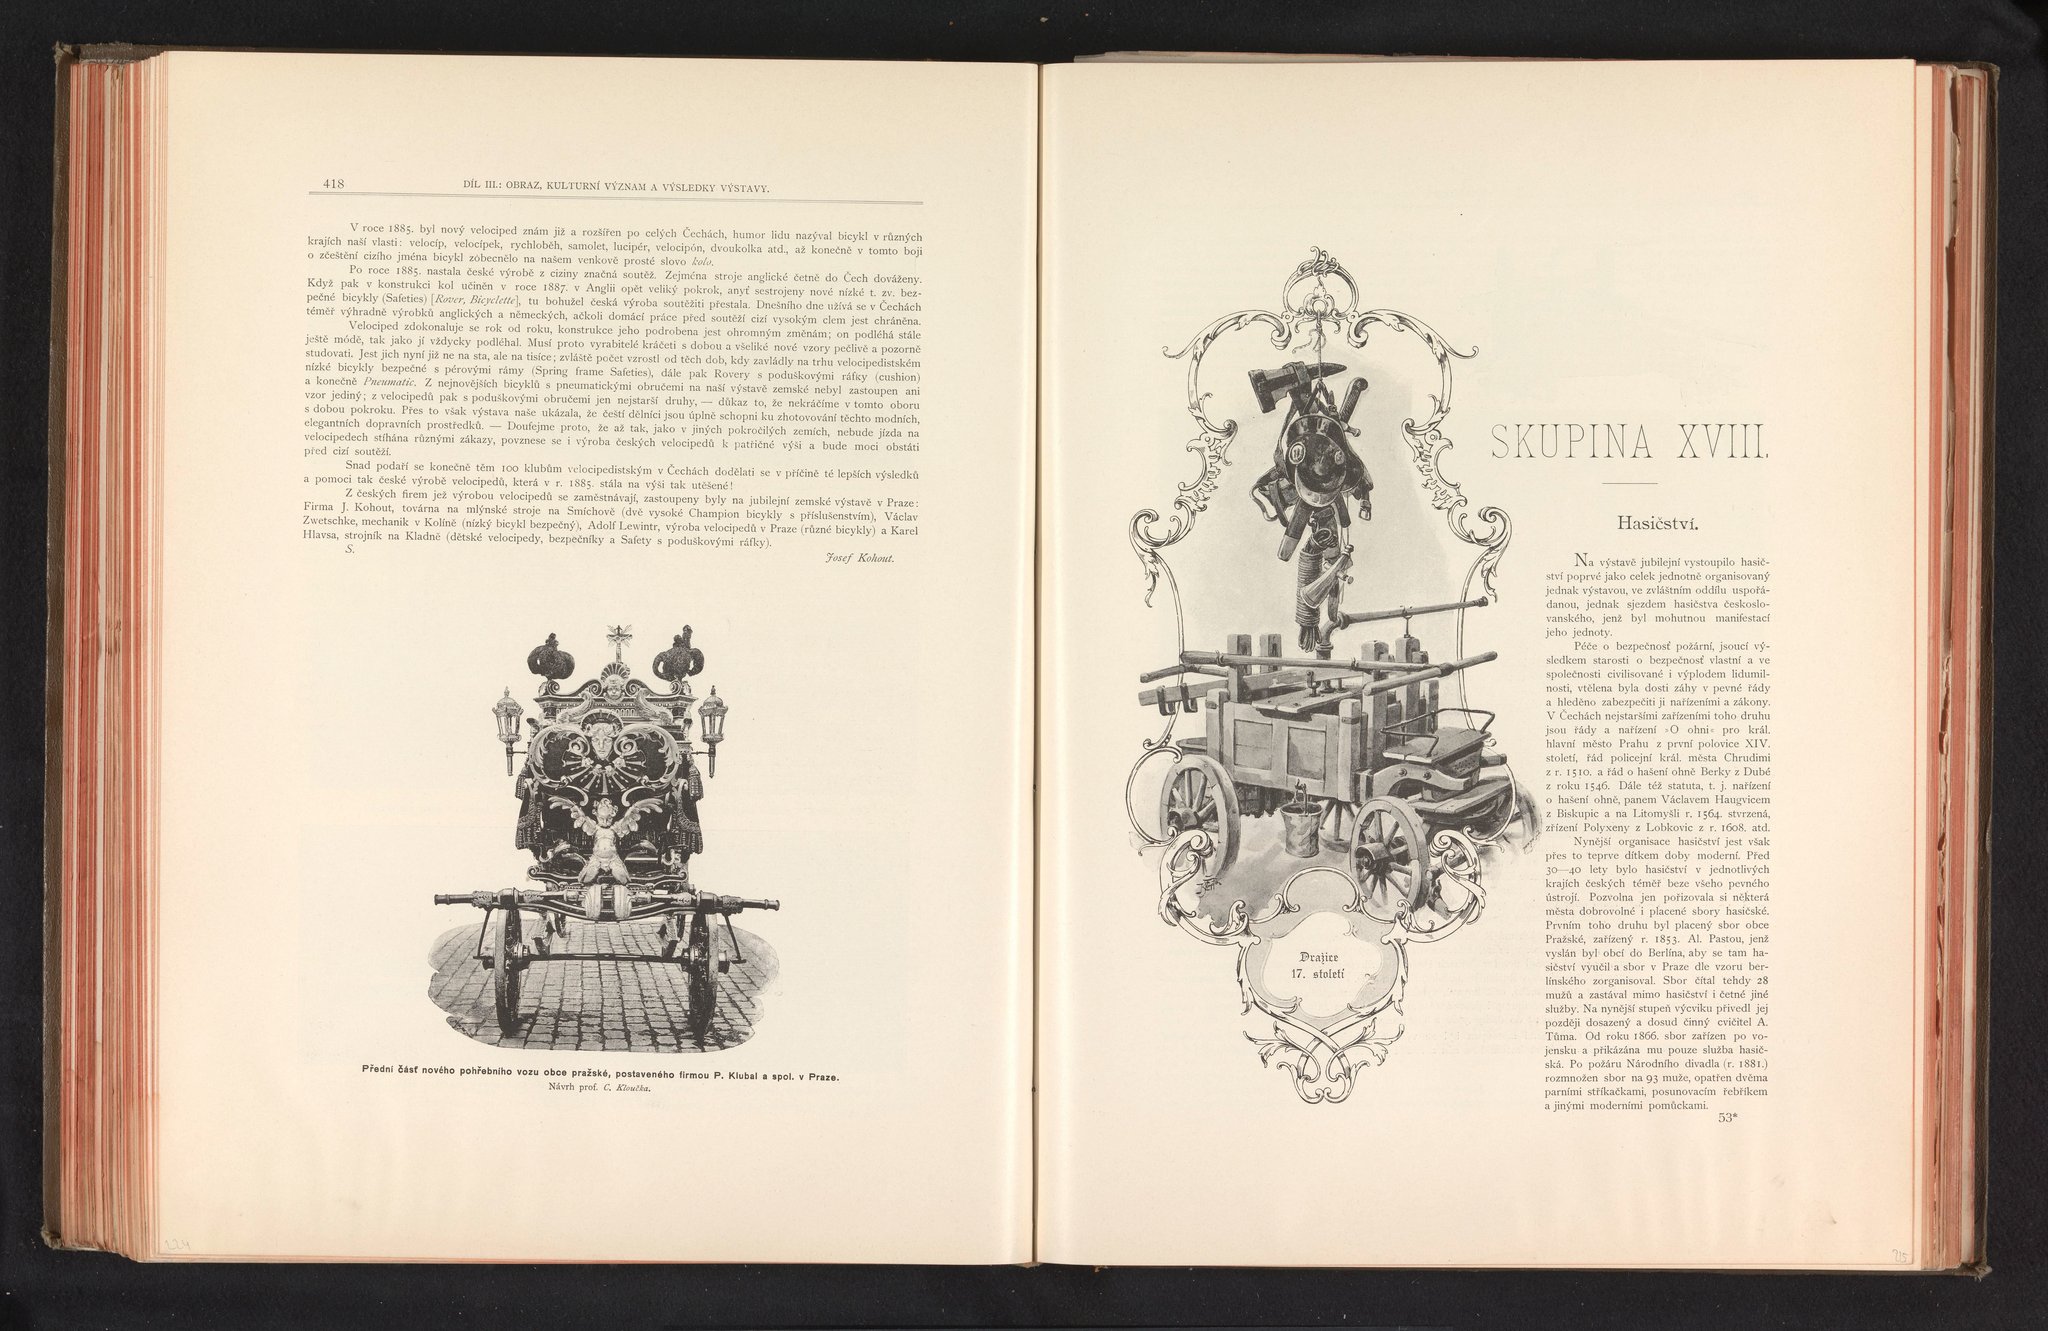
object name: reproduction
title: Fotoreproductie van een tekening, voorstellende een brandweerwagen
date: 1890-1895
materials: paper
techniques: autotype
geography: prague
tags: fire-engine